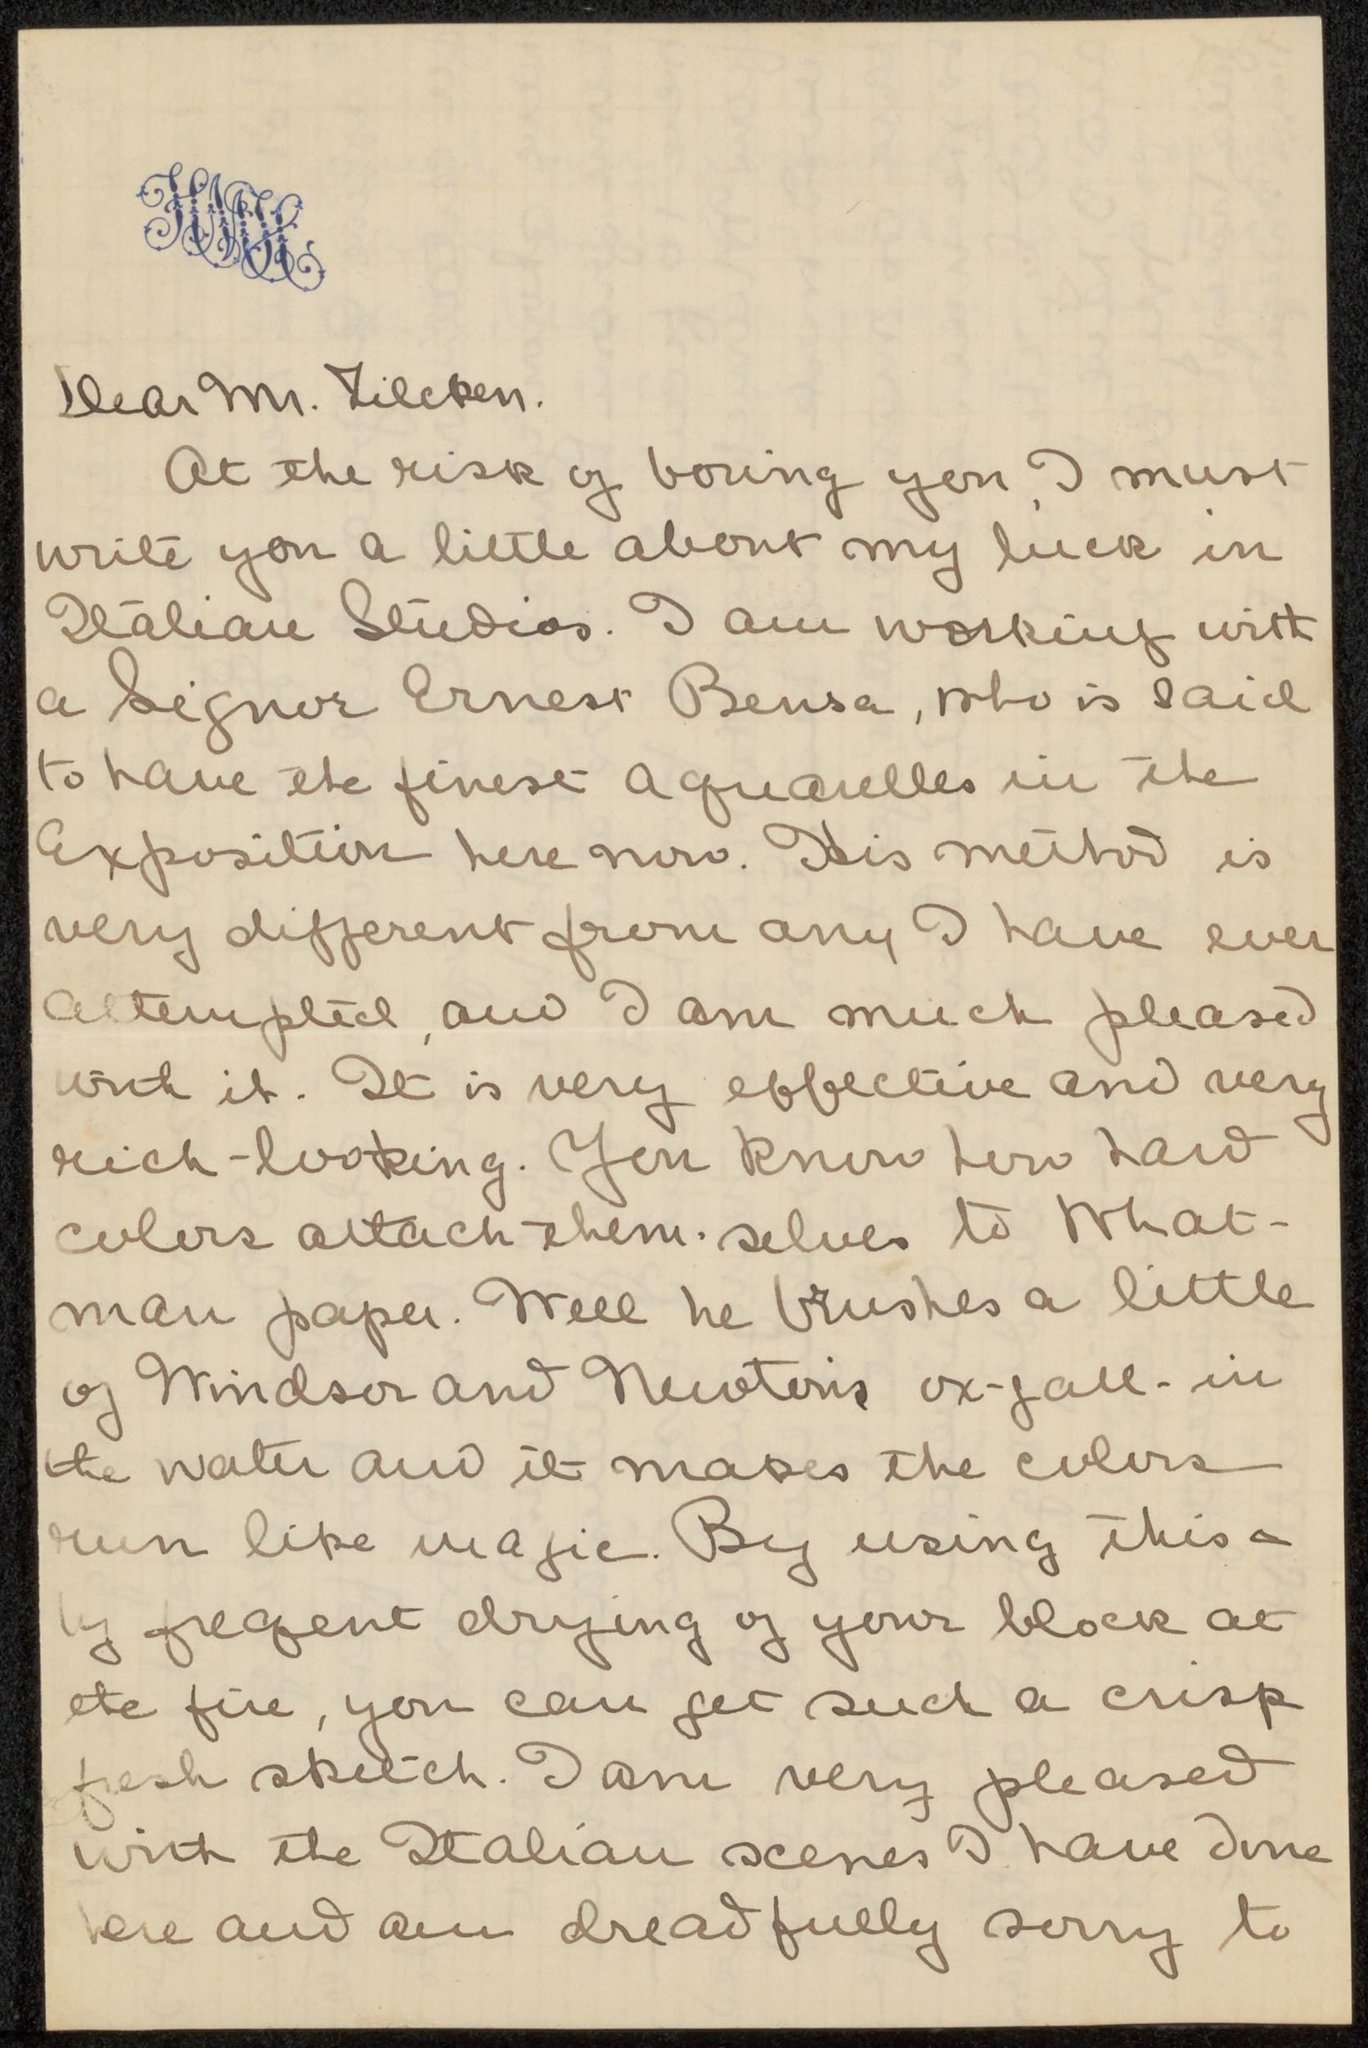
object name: letter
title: Brief aan Philip Zilcken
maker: helen m. holmes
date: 1897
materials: ink, paper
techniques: pen, printing, writing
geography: florence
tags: the hague, painter, draughtsman, philip zilcken, drawing, italy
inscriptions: seal, collector's mark: ‘RPK’